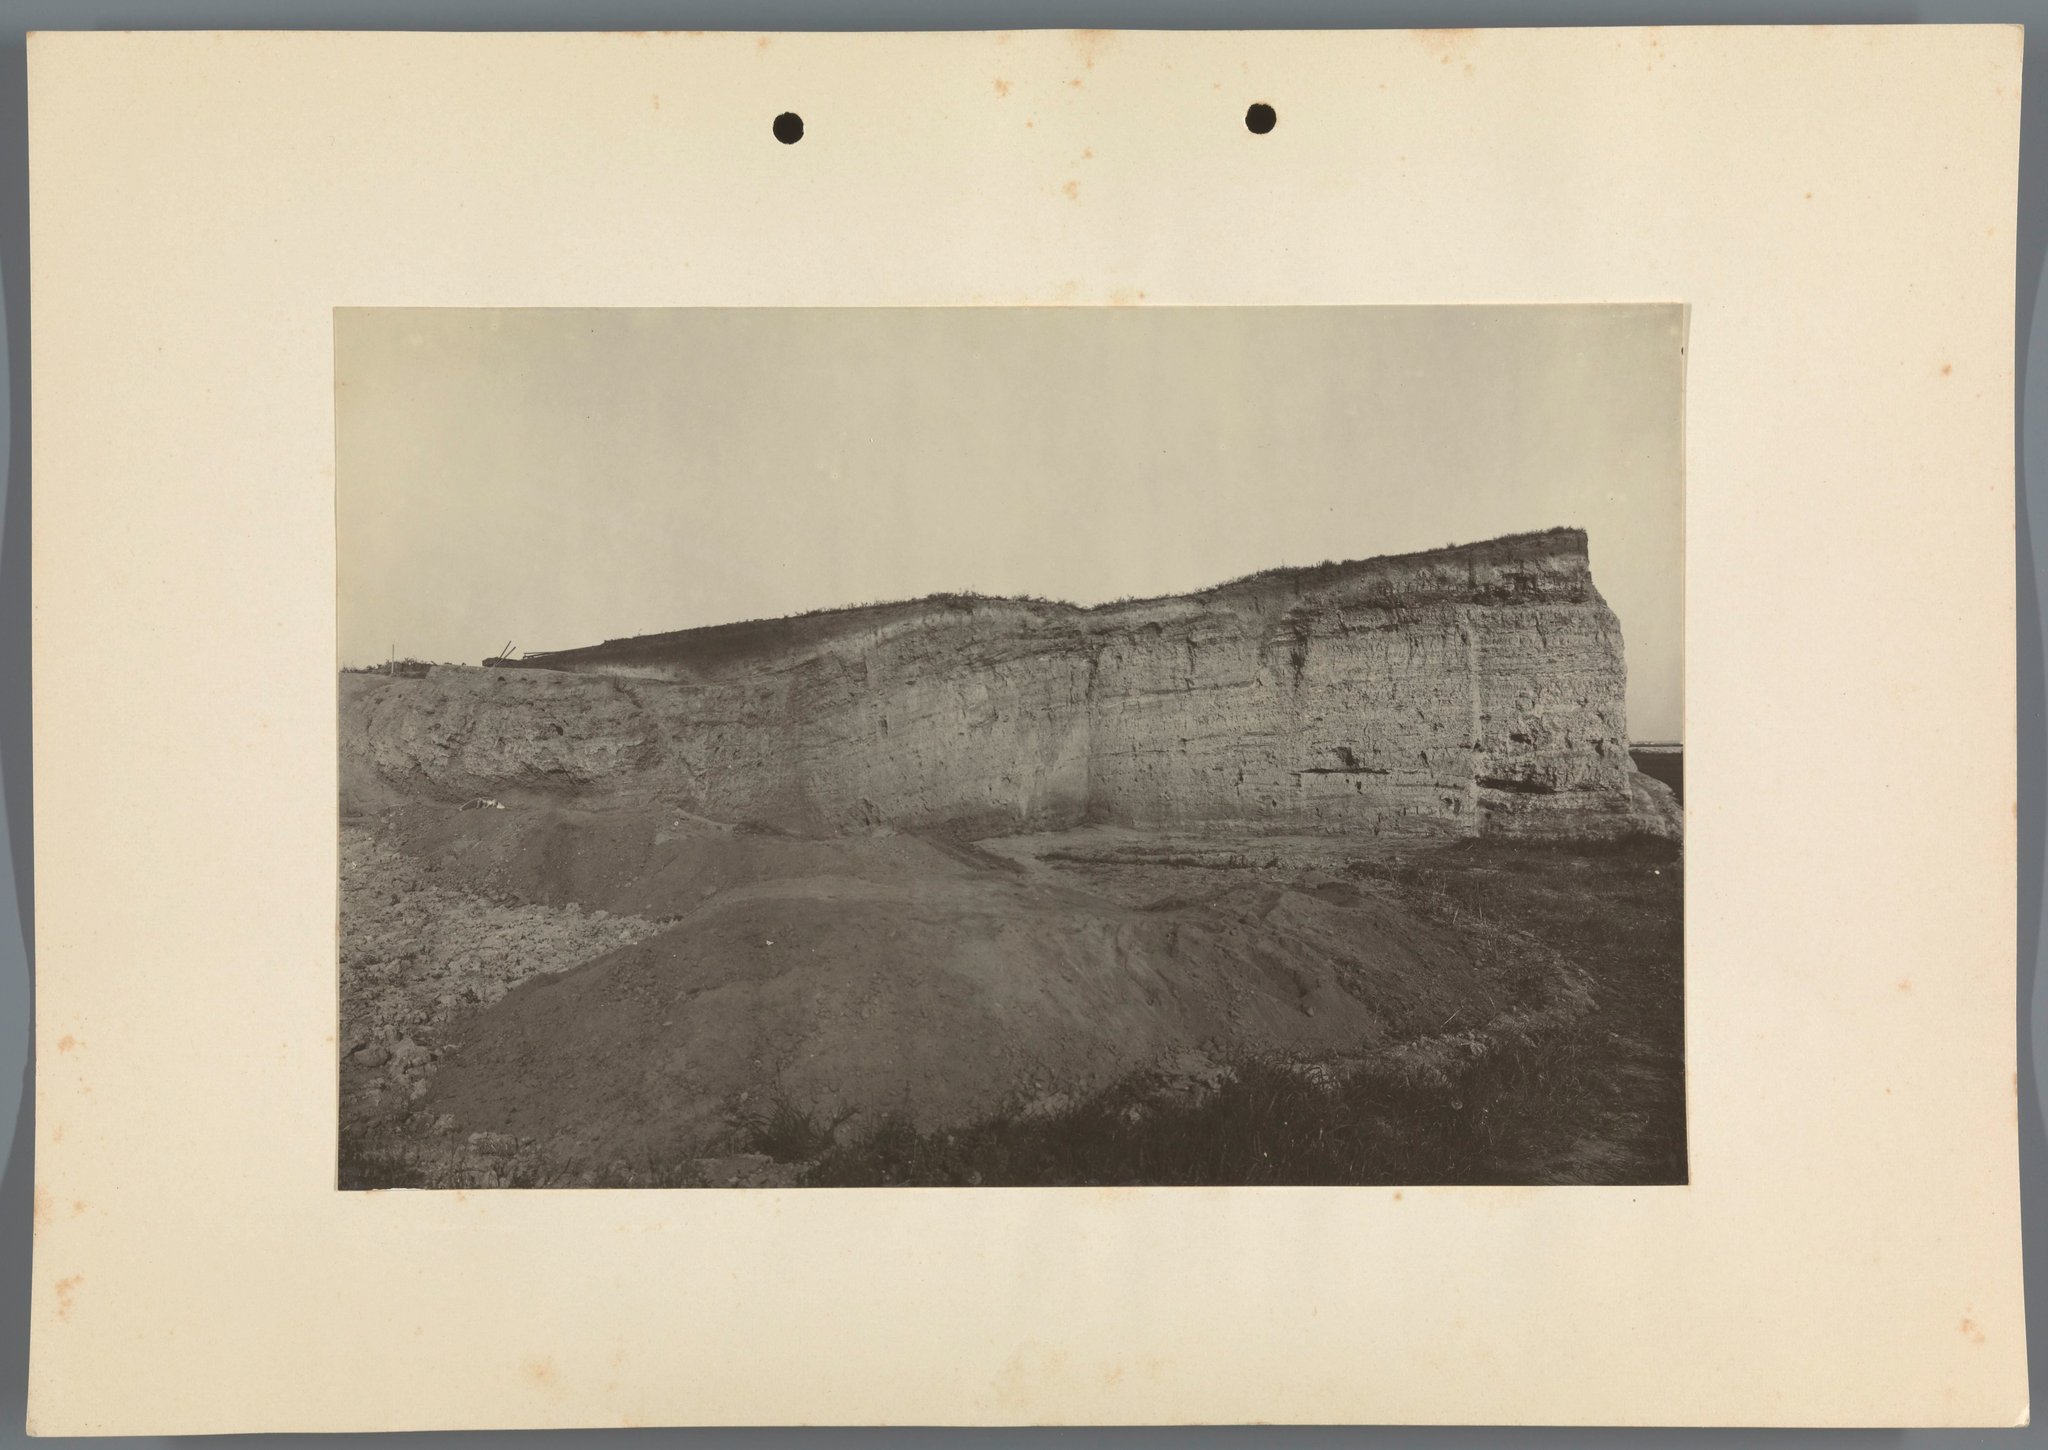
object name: photograph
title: Archeologische opgravingen bij een terp, Tószeg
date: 1928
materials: paper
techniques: gelatin silver print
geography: hungary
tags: excavation ~ archaeology, mound, verge